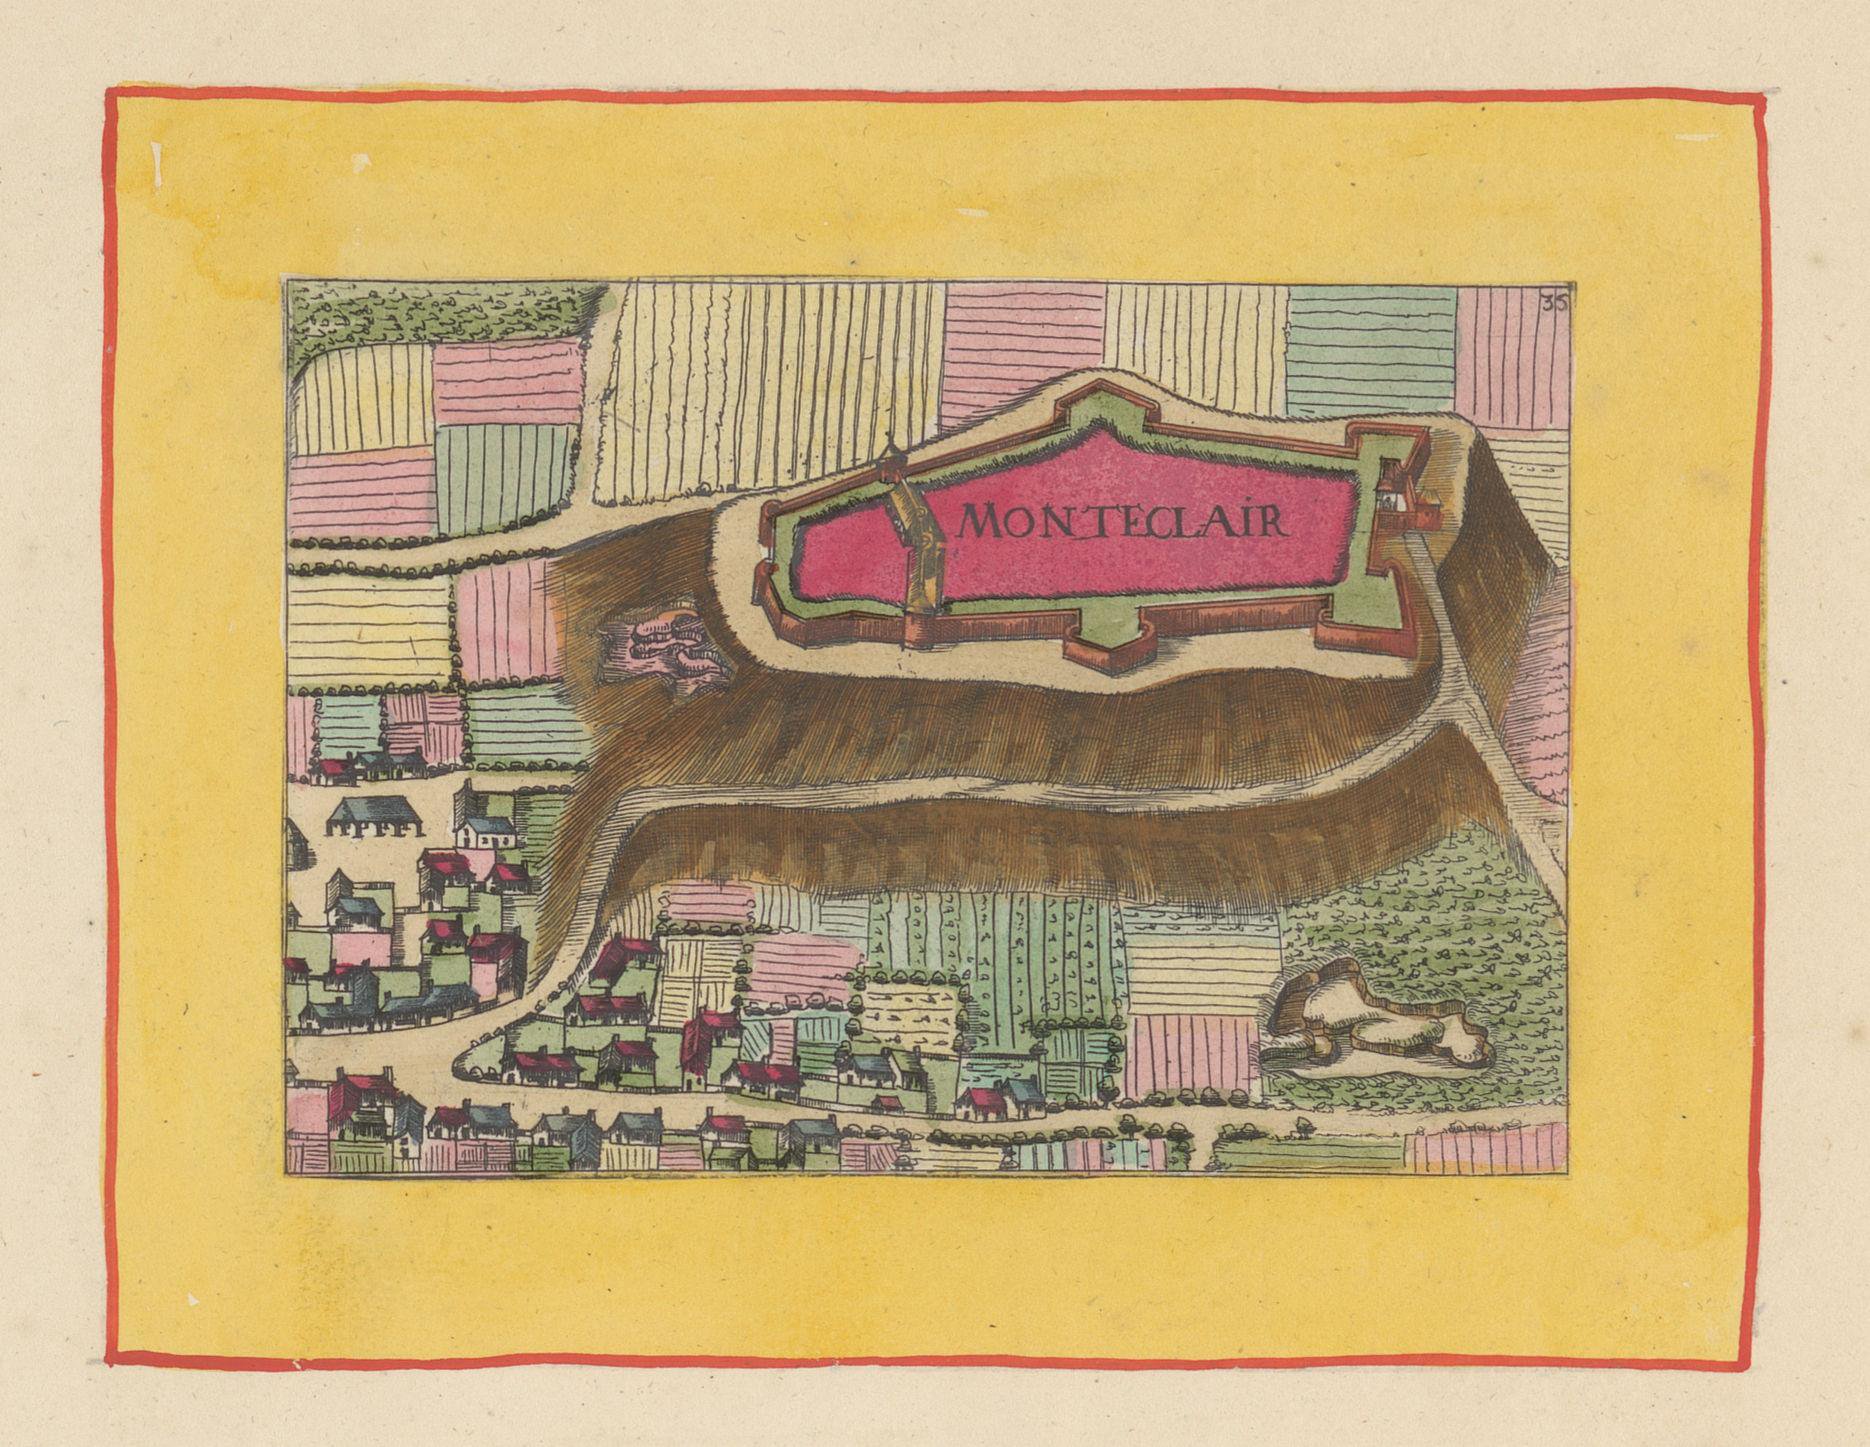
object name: area plan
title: Monteclair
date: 1638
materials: paper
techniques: engraving, hand coloring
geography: the hague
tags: maps of cities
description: Prent uit: Tassin, Christophe. Les plans et profils de toutes les principales villes et lieux considérables de France (...). Parijs: Michel van Lochom, 1638, plattegrond 35 uit het deel 'Champagne'.